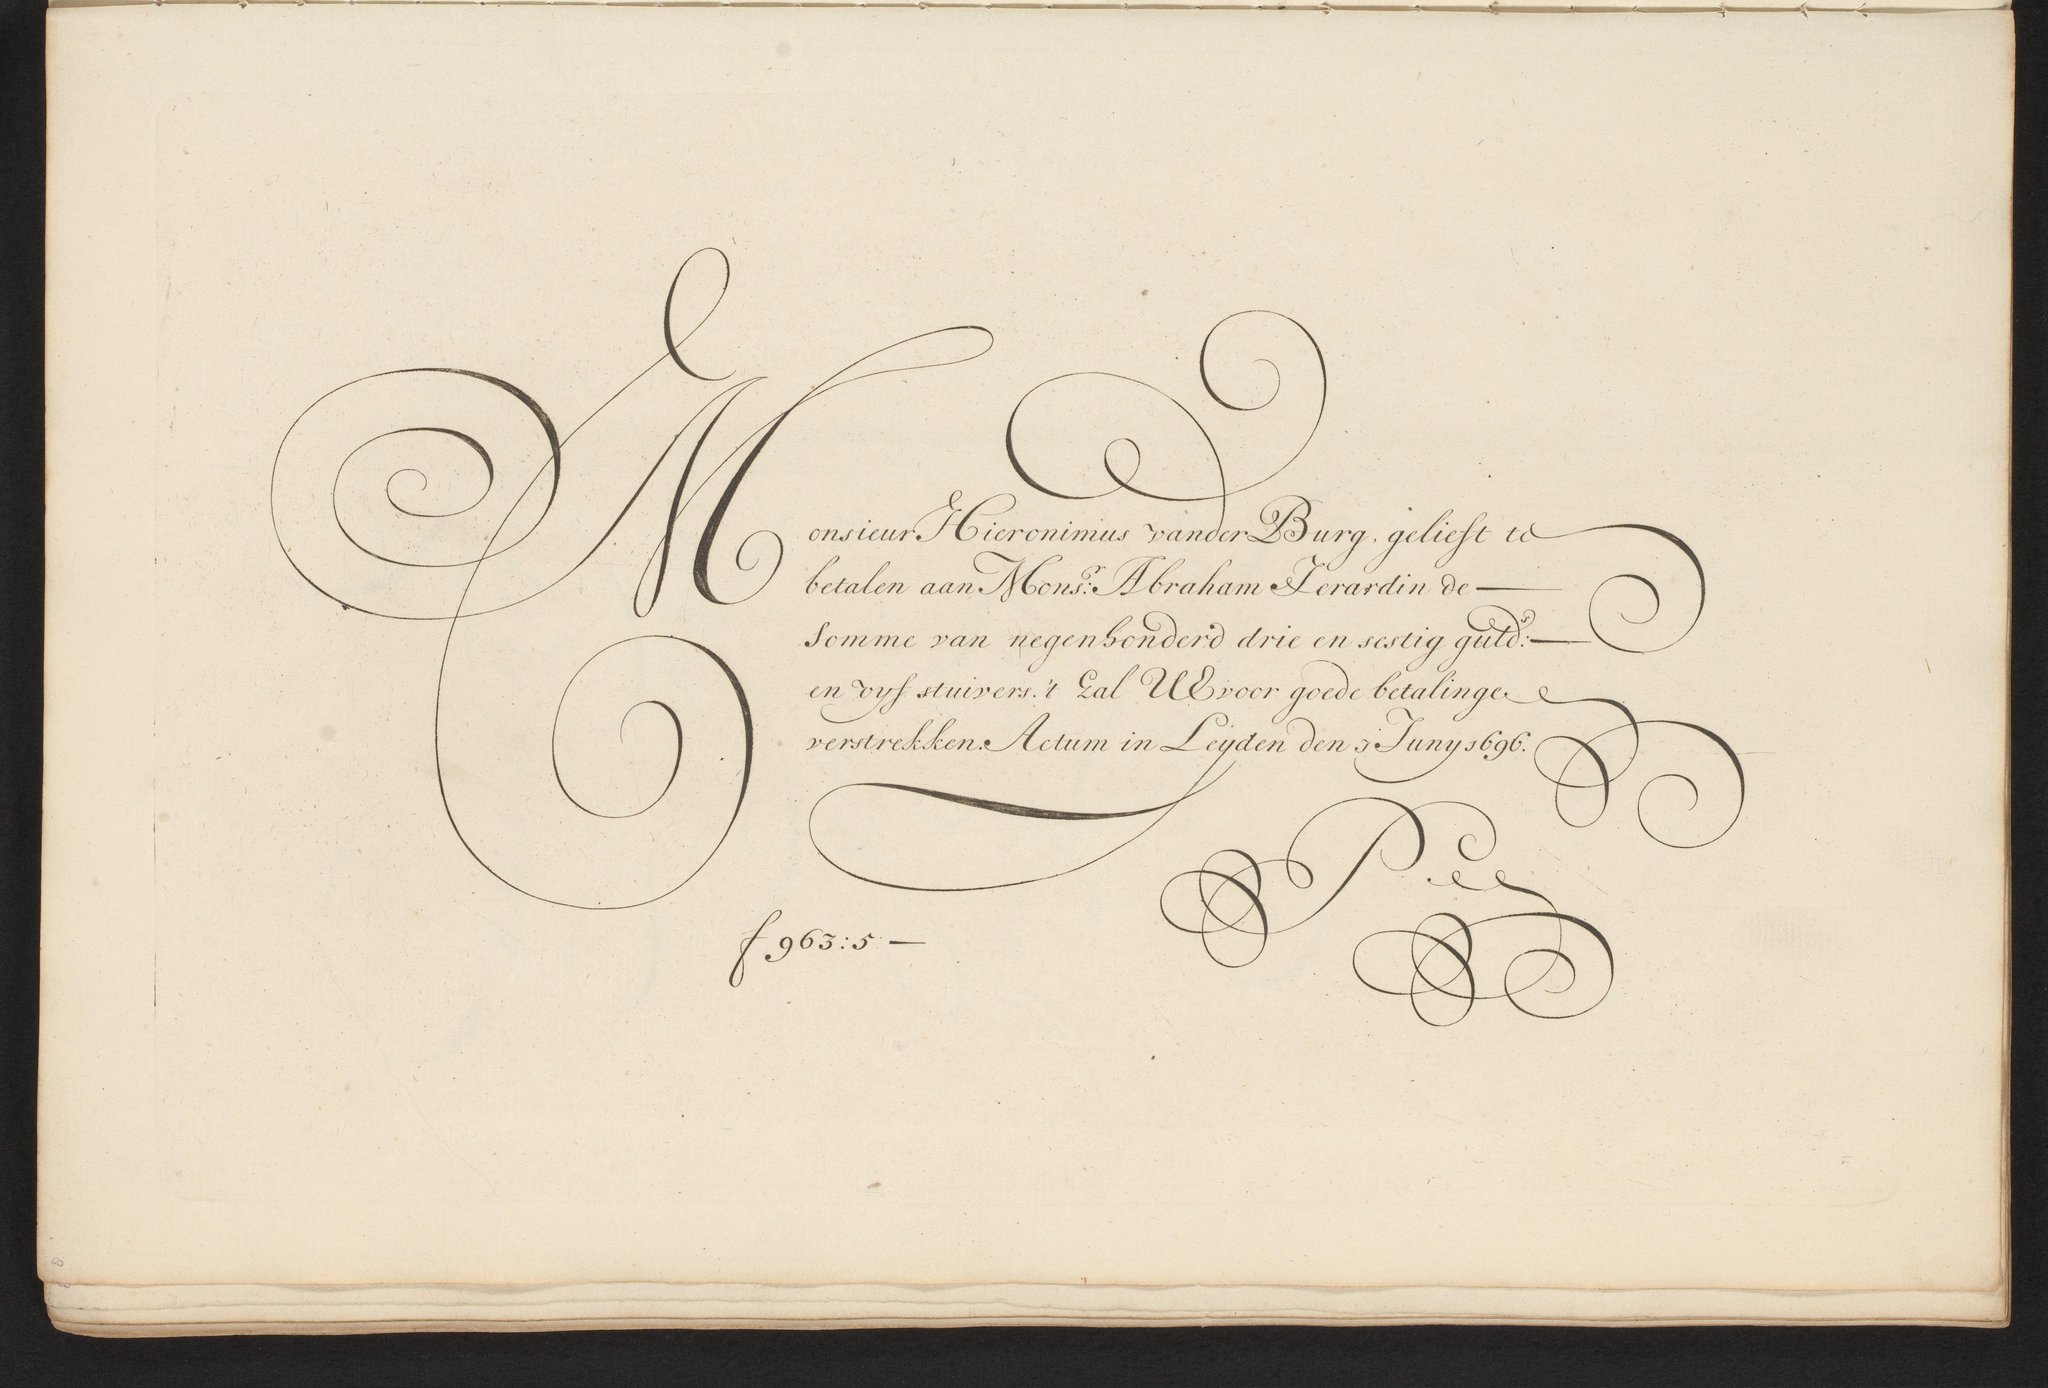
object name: album leaf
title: Schrijfvoorbeeld: Monsieur Hieronimus vander Burg (...)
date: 1660-1751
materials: paper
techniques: engraving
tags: calligraphy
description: Schrijfvoorbeeld met vijf regels tekst in het Nederlands: Monsieur Hieronimus vander Burg ... De prent maakt deel uit van een album